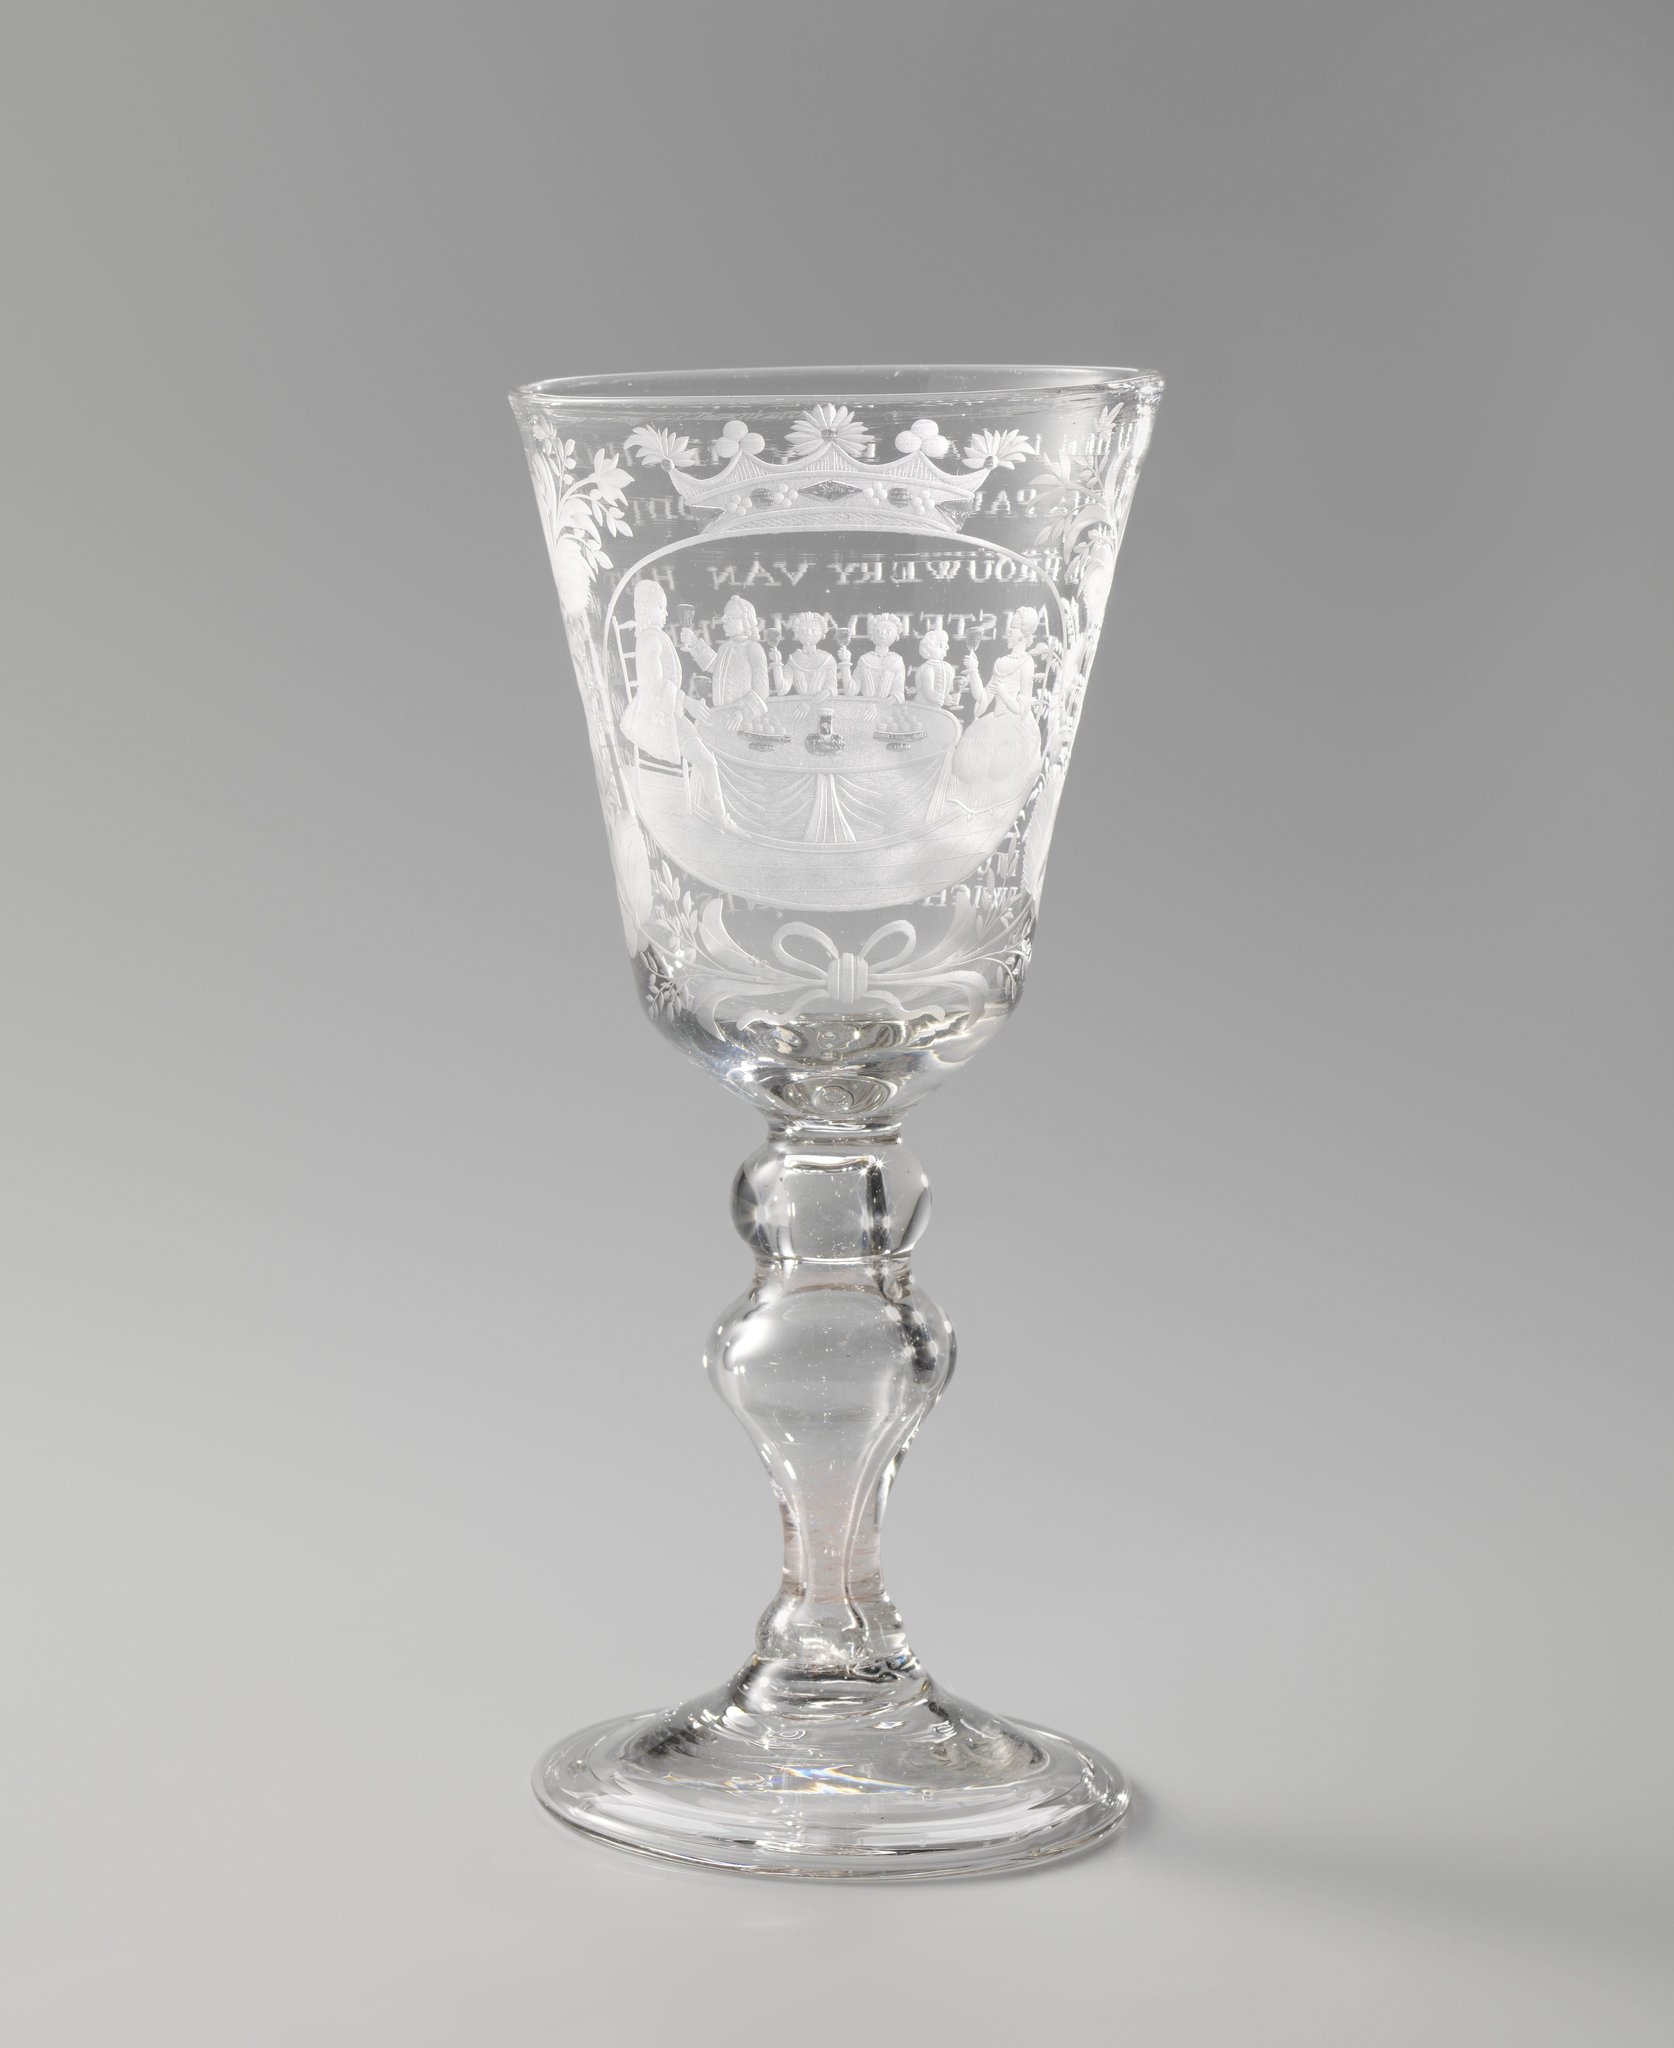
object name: goblet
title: Wine glass for the Amsterdam Arms Brewery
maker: Anonymous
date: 1731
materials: glass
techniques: glassblowing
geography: germany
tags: banquet of elegant company (+ toast at meal, banquet), amsterdam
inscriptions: inscription: ‘1731 DEN 13 MAY REYNIER HILLEGAART // MARIA PAURZOOY . GOD ZEEGENT // DE BROUWERY VAN HET AMSTERDAMSCHE // WAAPEN SOO LANG // DAAR IMANT LEEFT // VAN 'T BLOET, GODT // ZEEGENT HAAR HIER // IN OVERVLOET, EN IN // EWIGHYT TE ONTSLAPEN’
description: translation of inscription: 1731 the 13th of May, Reynier Hillegaart / Maria Paurzooy. God Bless / the brewery of the Amsterdam Arms / as long as one of the family is living / may God / his blessing in abundance be giving / and enjoy peace in eternity